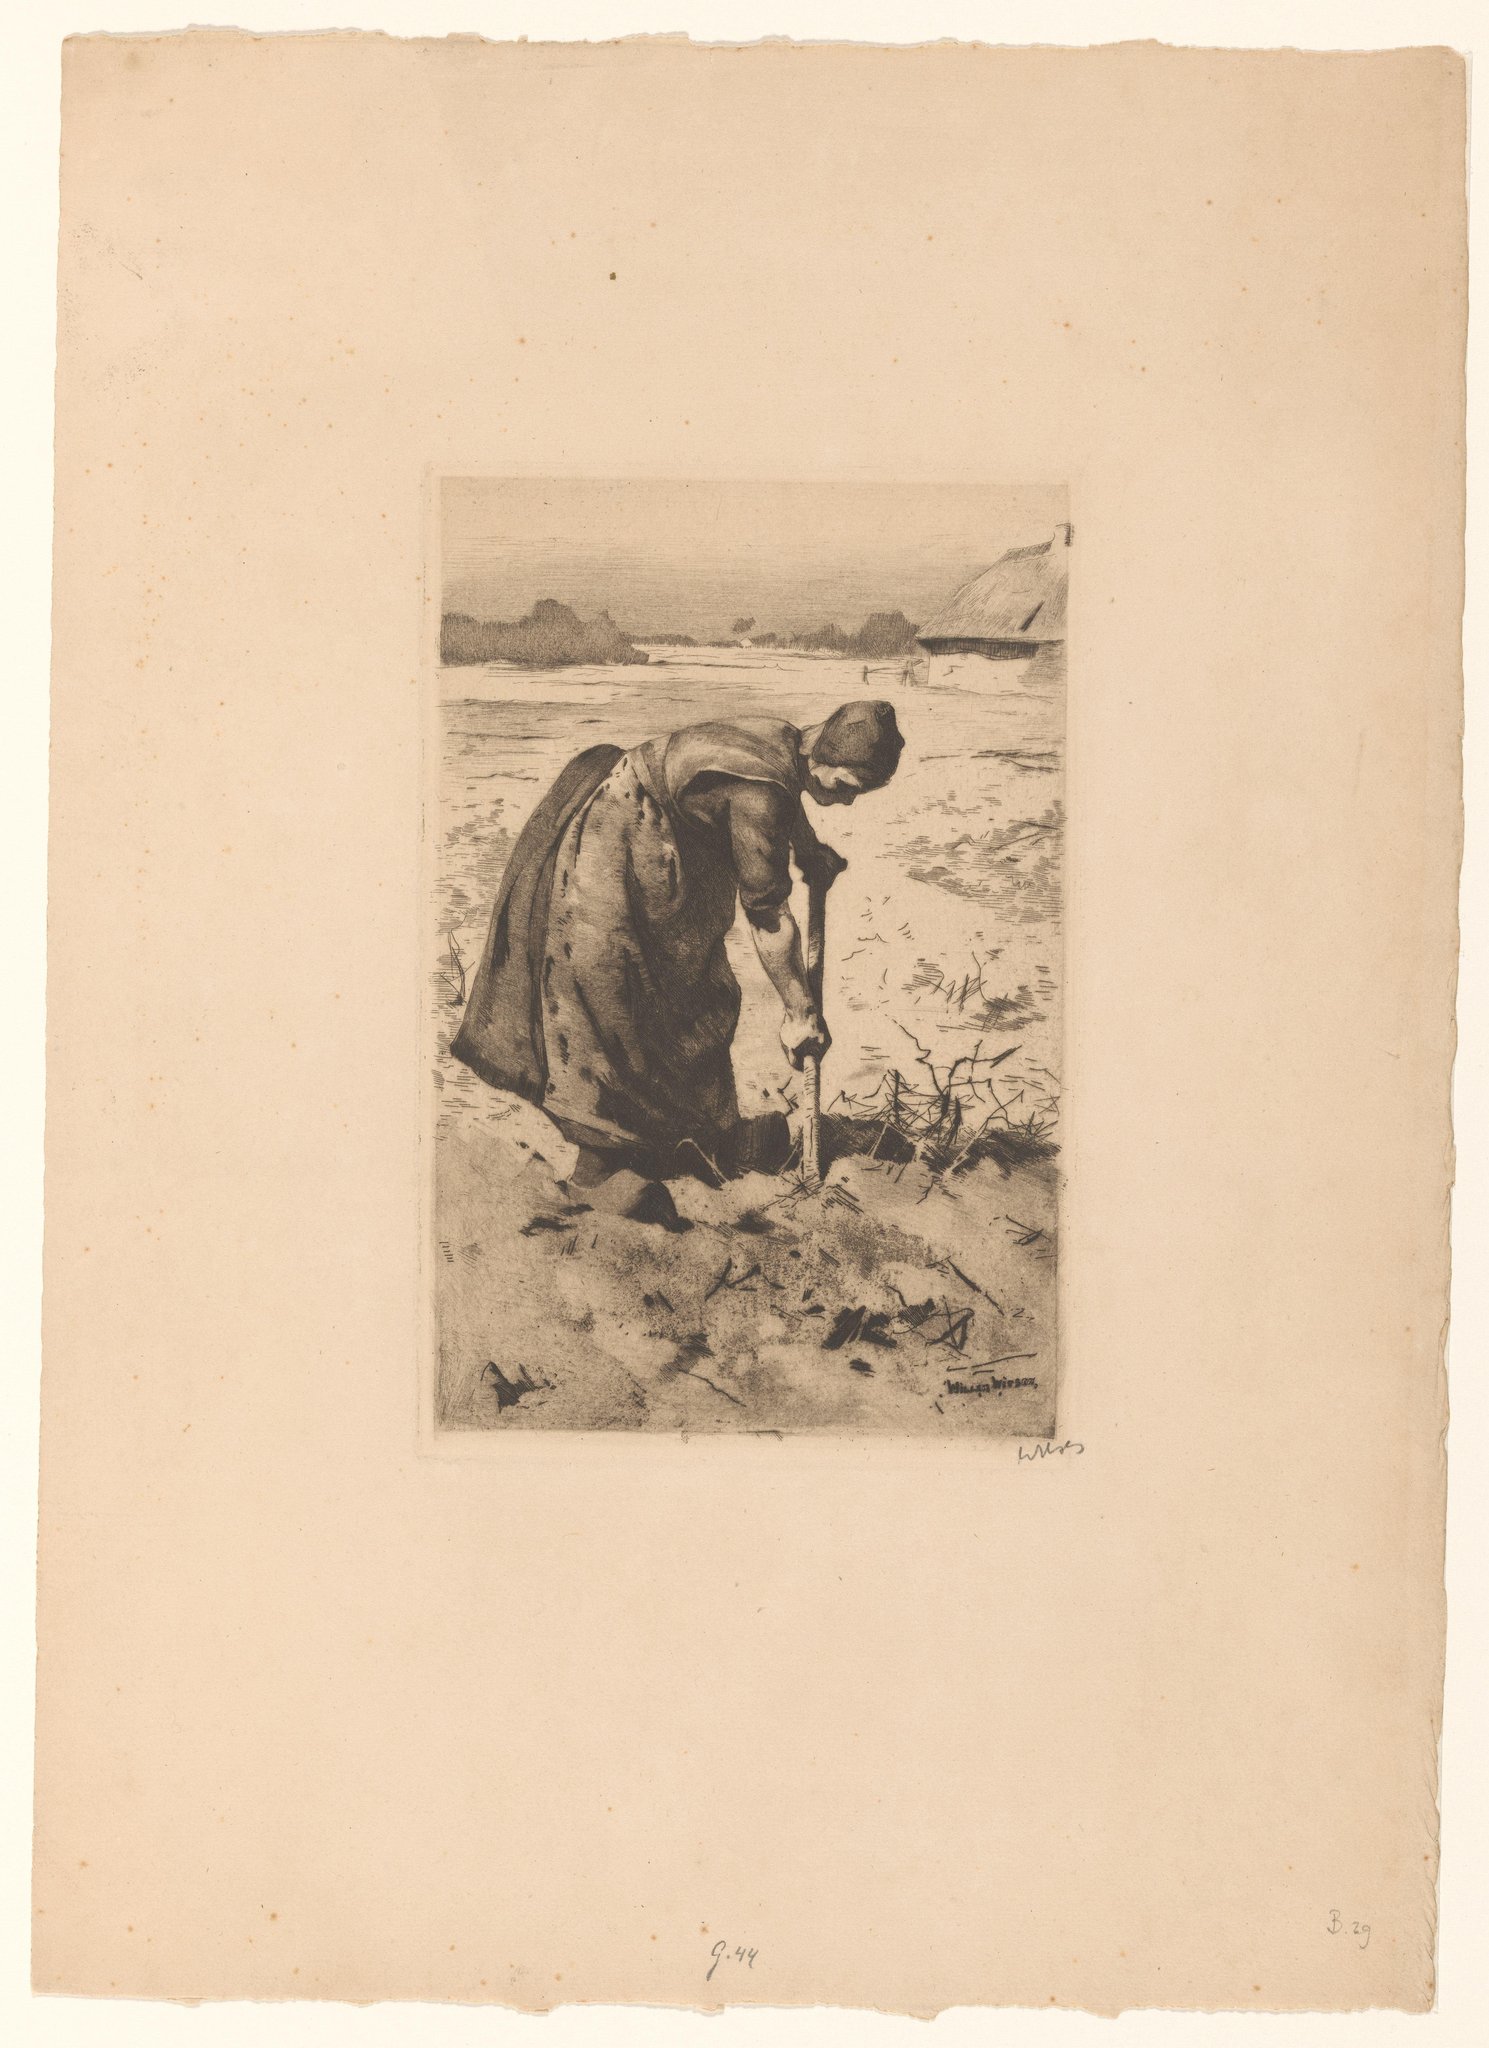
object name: print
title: Spittende boerin op het land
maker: willem witsen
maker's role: draughtsman, painter, print maker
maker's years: 1860-1923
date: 1886-1887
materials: paper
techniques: etching, intaglio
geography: ewijkshoeve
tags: farmers - aa - female farmer, farmer's wife, digging (industrial process)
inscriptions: collector's mark: Lugt 2228, watermark:, signature: ‘Witsen’